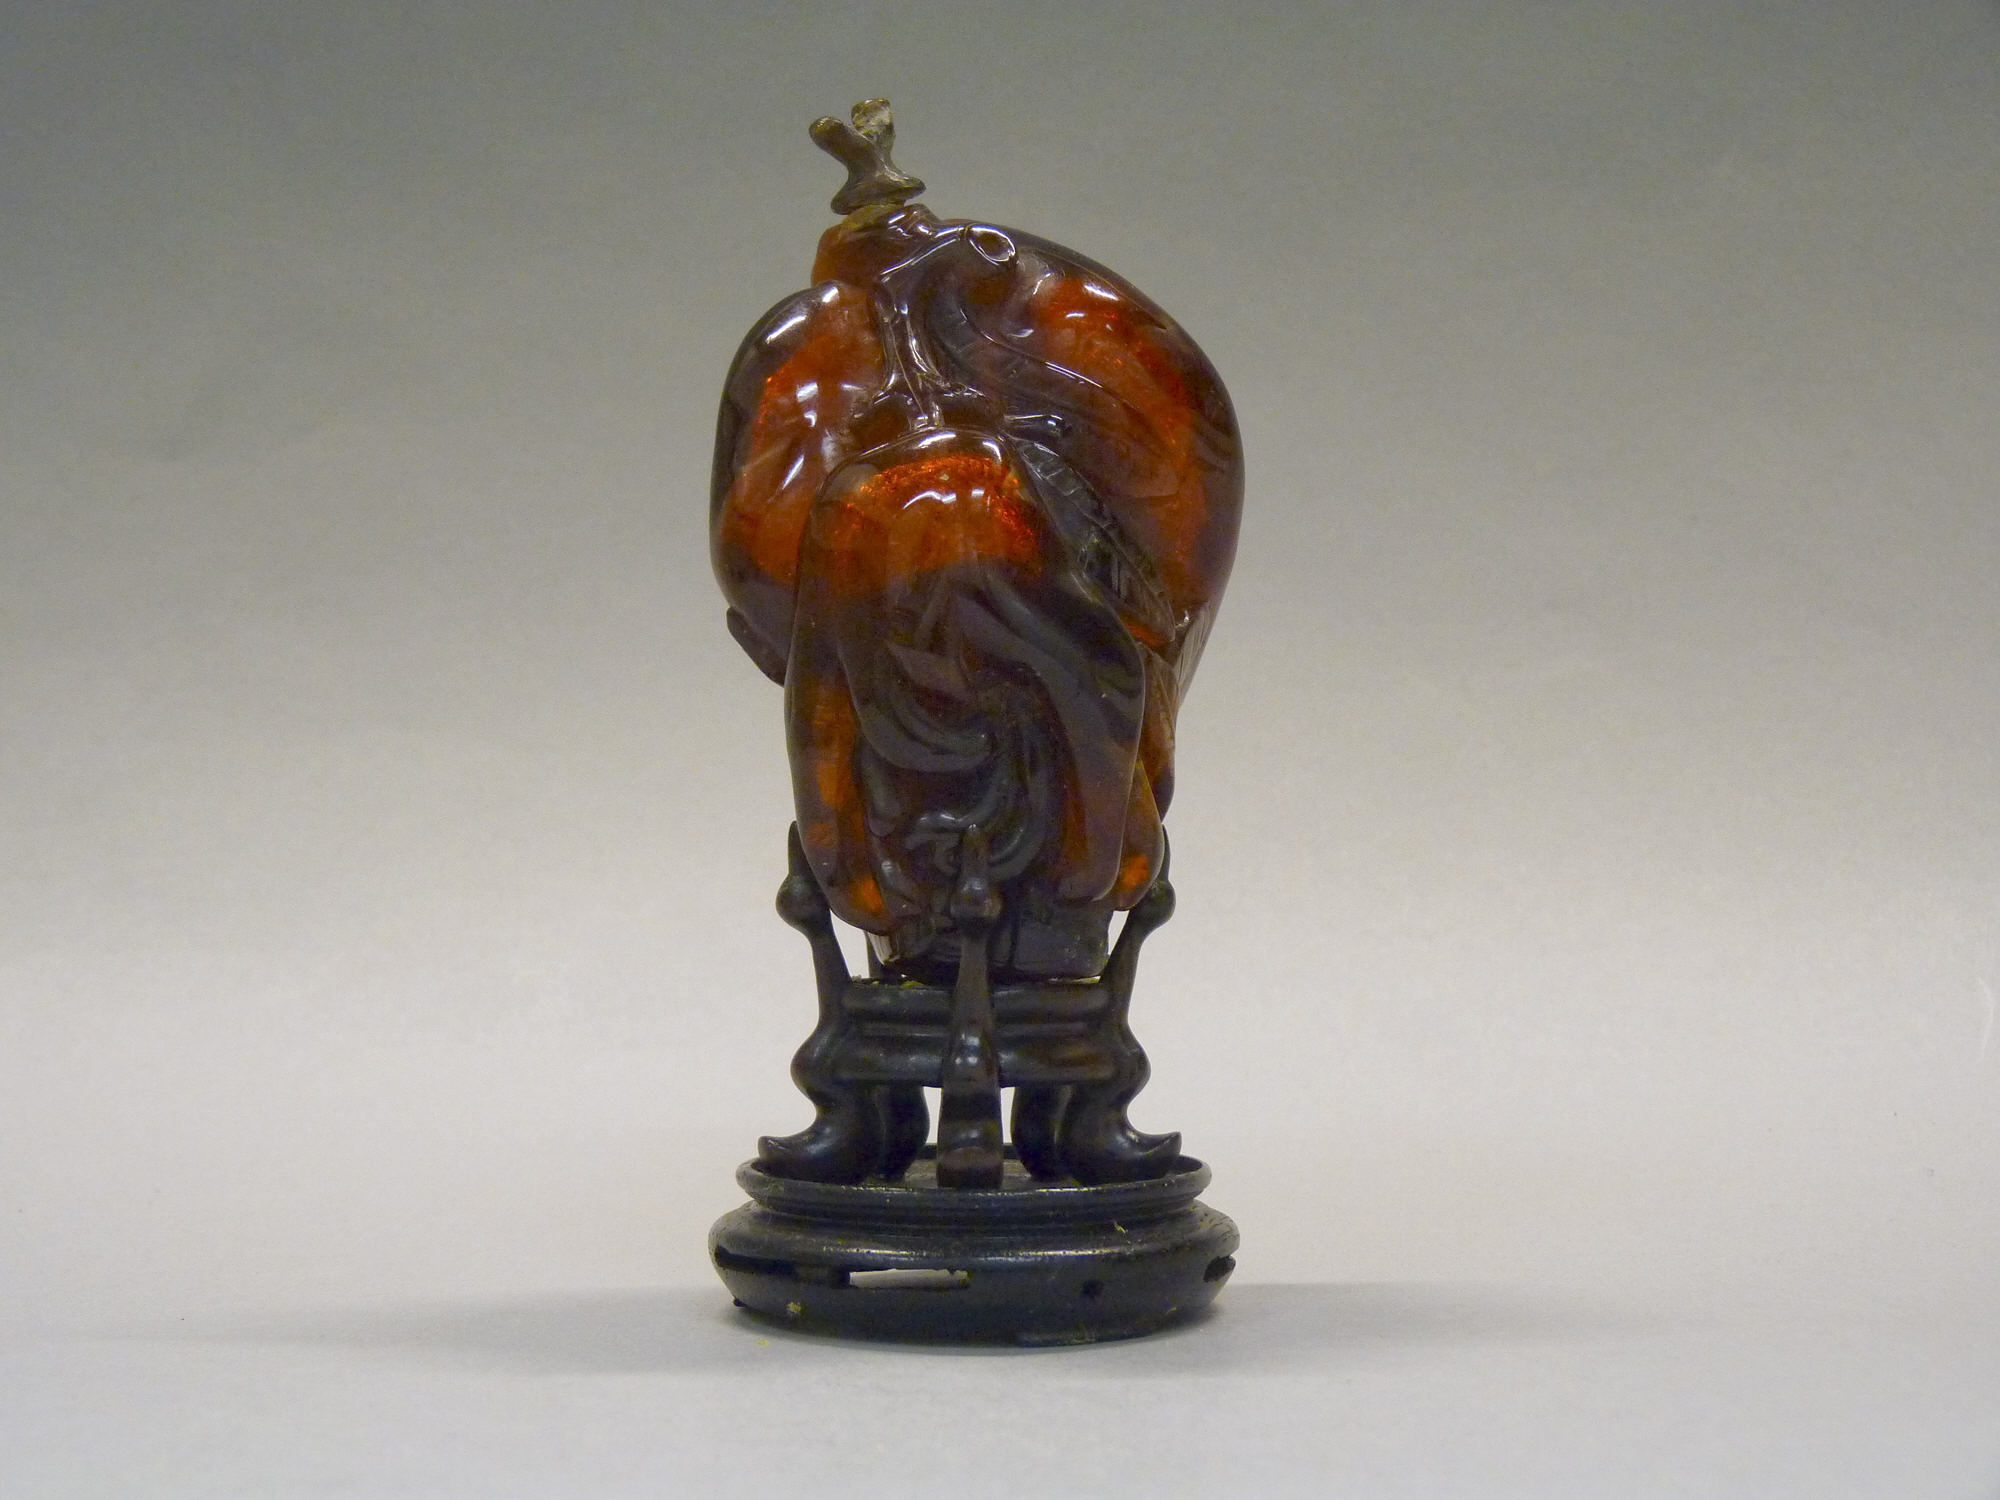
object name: snuff bottle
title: Snuff Bottle with Stopper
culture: chinese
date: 1736-1795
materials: amber, wood